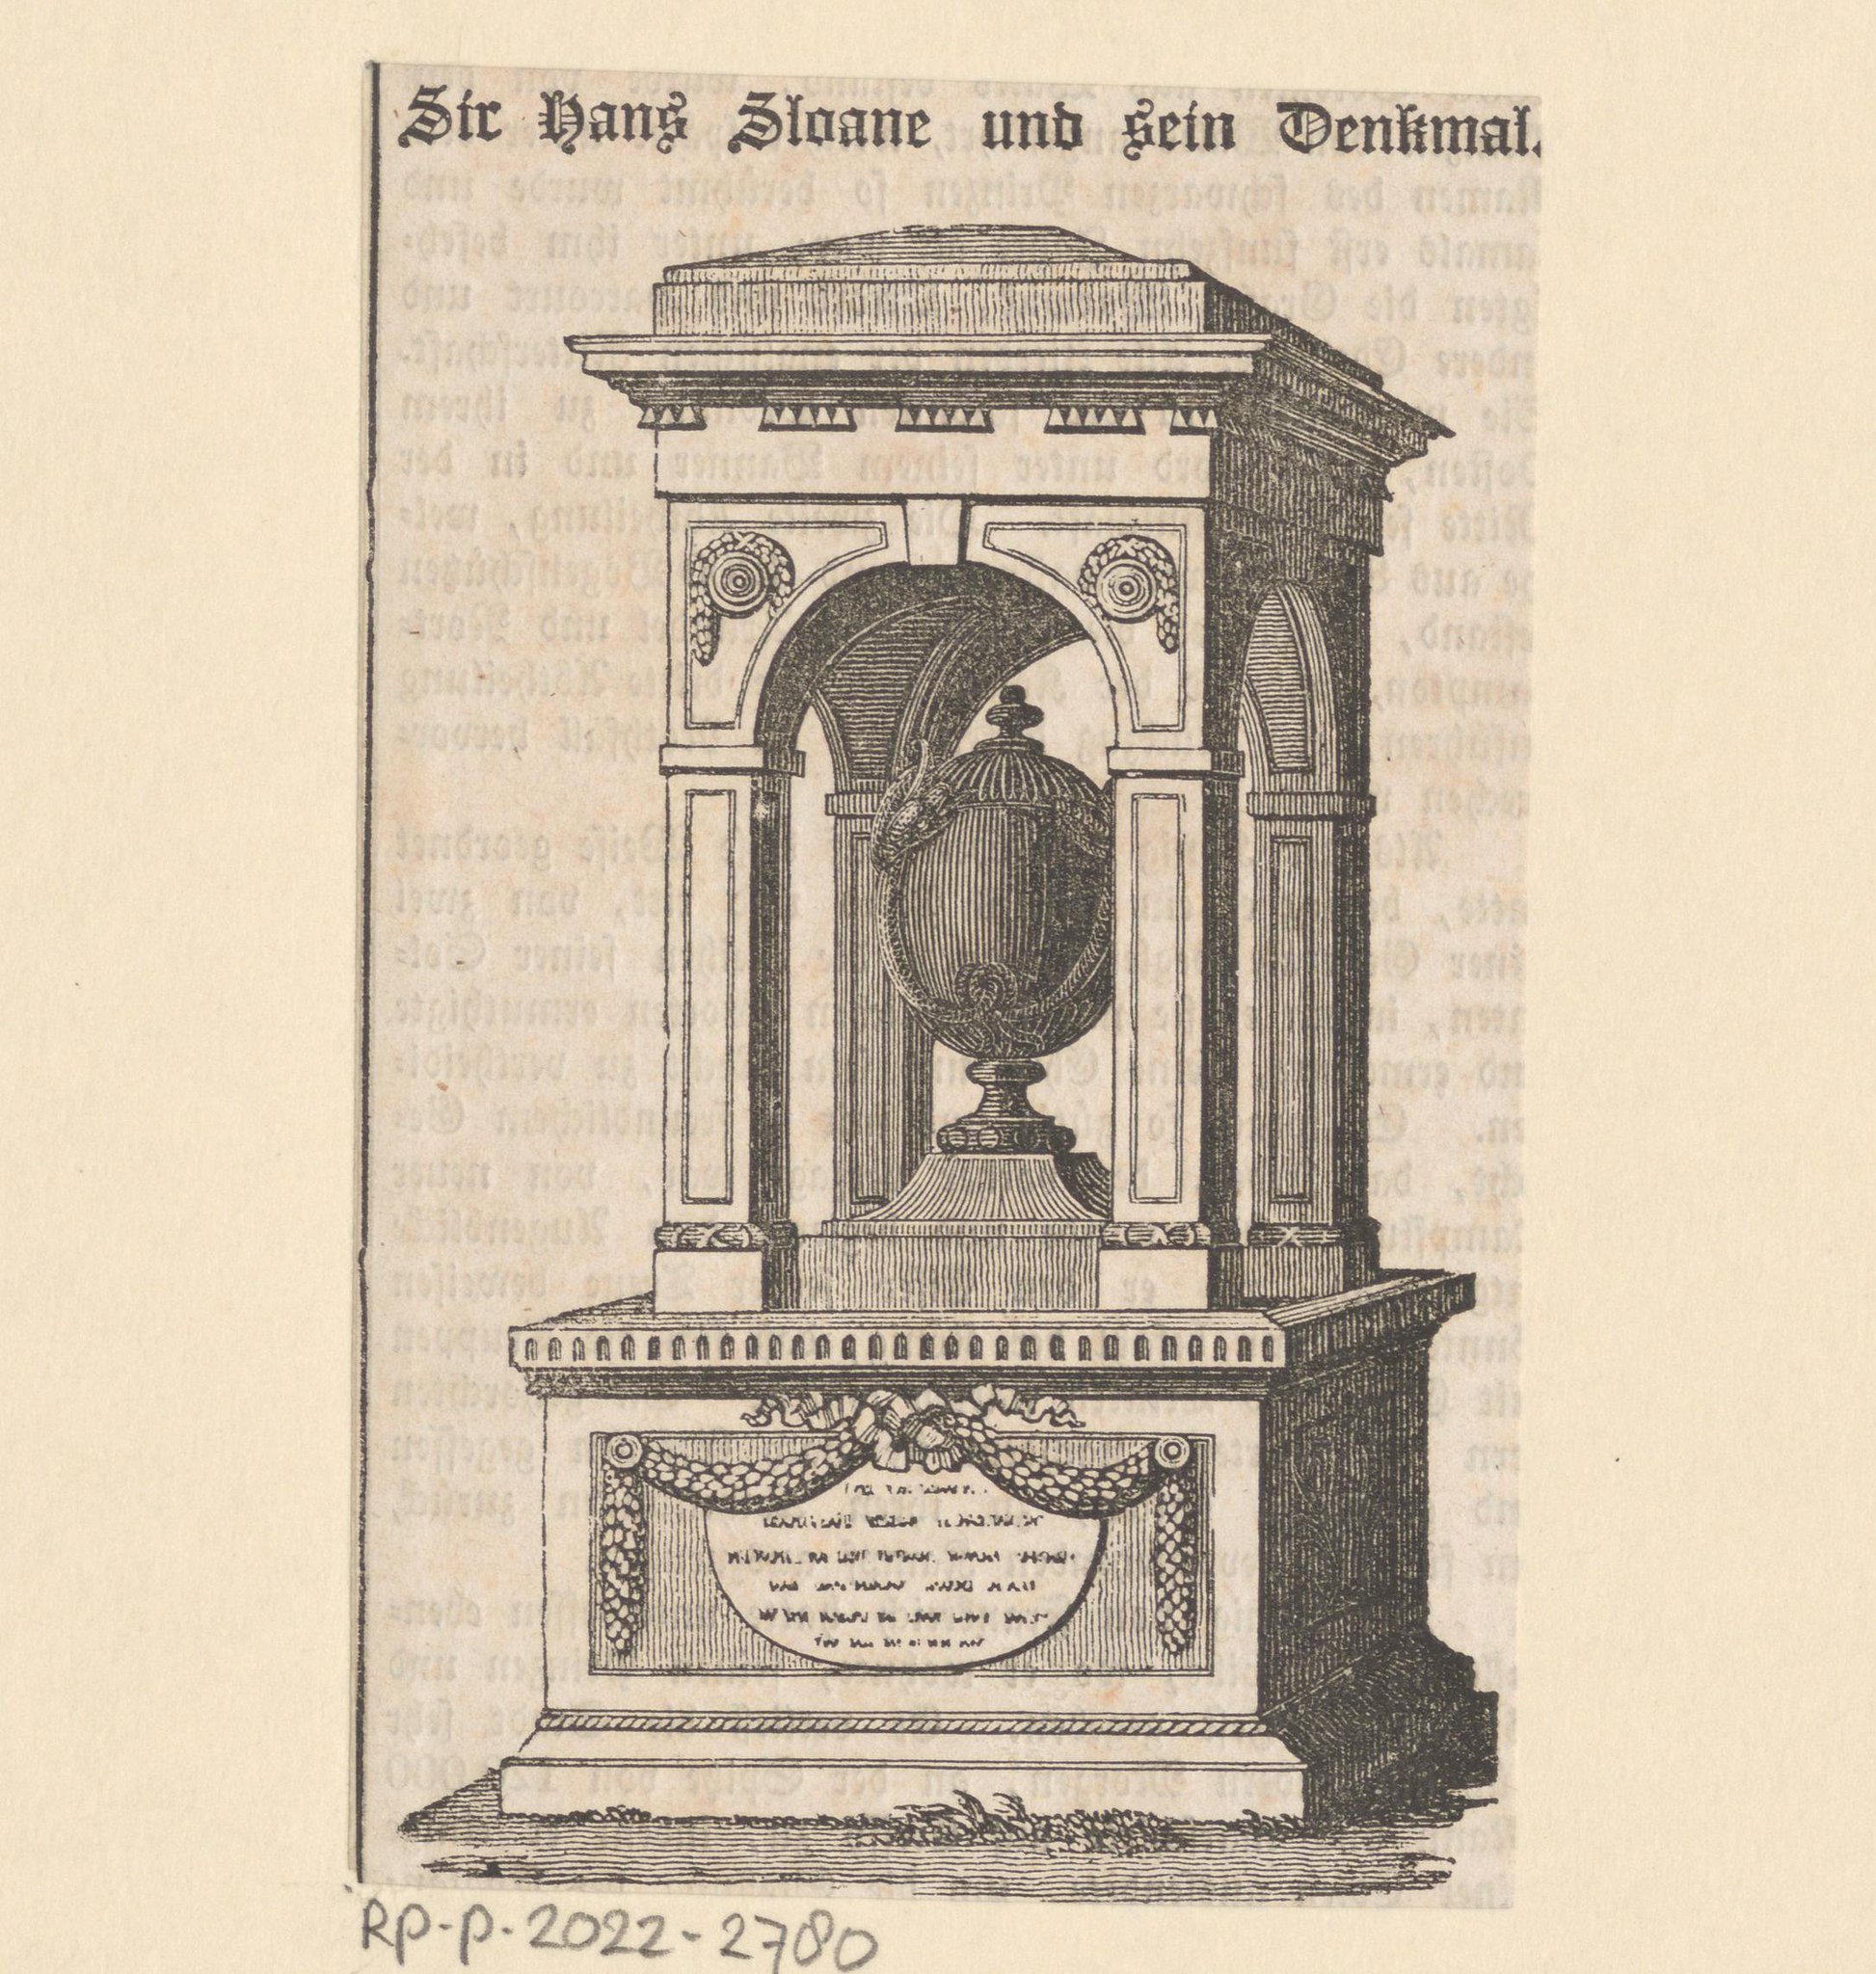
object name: print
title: Monument voor Hans Sloane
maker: Anonymous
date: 1753-1850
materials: paper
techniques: letterpress printing, engraving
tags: botany (+ portrait of scholar, scientist), historical persons, physician, doctor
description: Met eenregelig bovenschrift in het Duits.